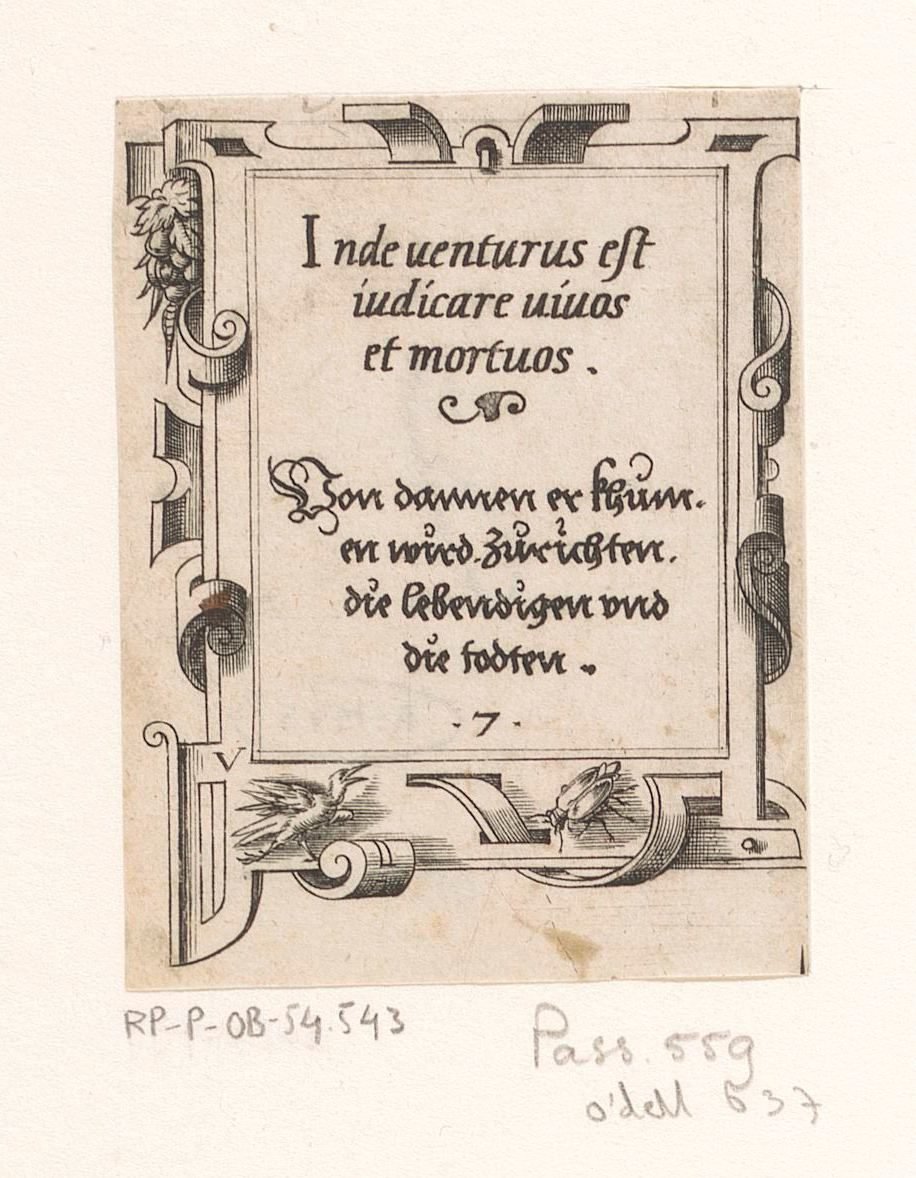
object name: print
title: Gebed in Latijn en Duits in een rolwerk omlijsting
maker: virgilius solis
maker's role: draughtsman, print maker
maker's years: 1514-1562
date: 1568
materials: paper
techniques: engraving, etching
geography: nuremberg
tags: scrollwork, strapwork ~ ornament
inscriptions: collector's mark: Lugt 240, collector's mark: Lugt 2228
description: Prent gebruikt voor het gebedenboek: Solis, Virgil. Ein New Künstlich Betbüchlein. Neurenberg: Hieronymus Petri, 1568. Bij elke prent met afbeelding van een apostel behoort een prent met een gebed in het Latijn en in het Duits. Bij elkaar horende prenten hebben dezelfde nummering en het monogram VS is steeds verspreid over twee bladen met dezelfde nummering.